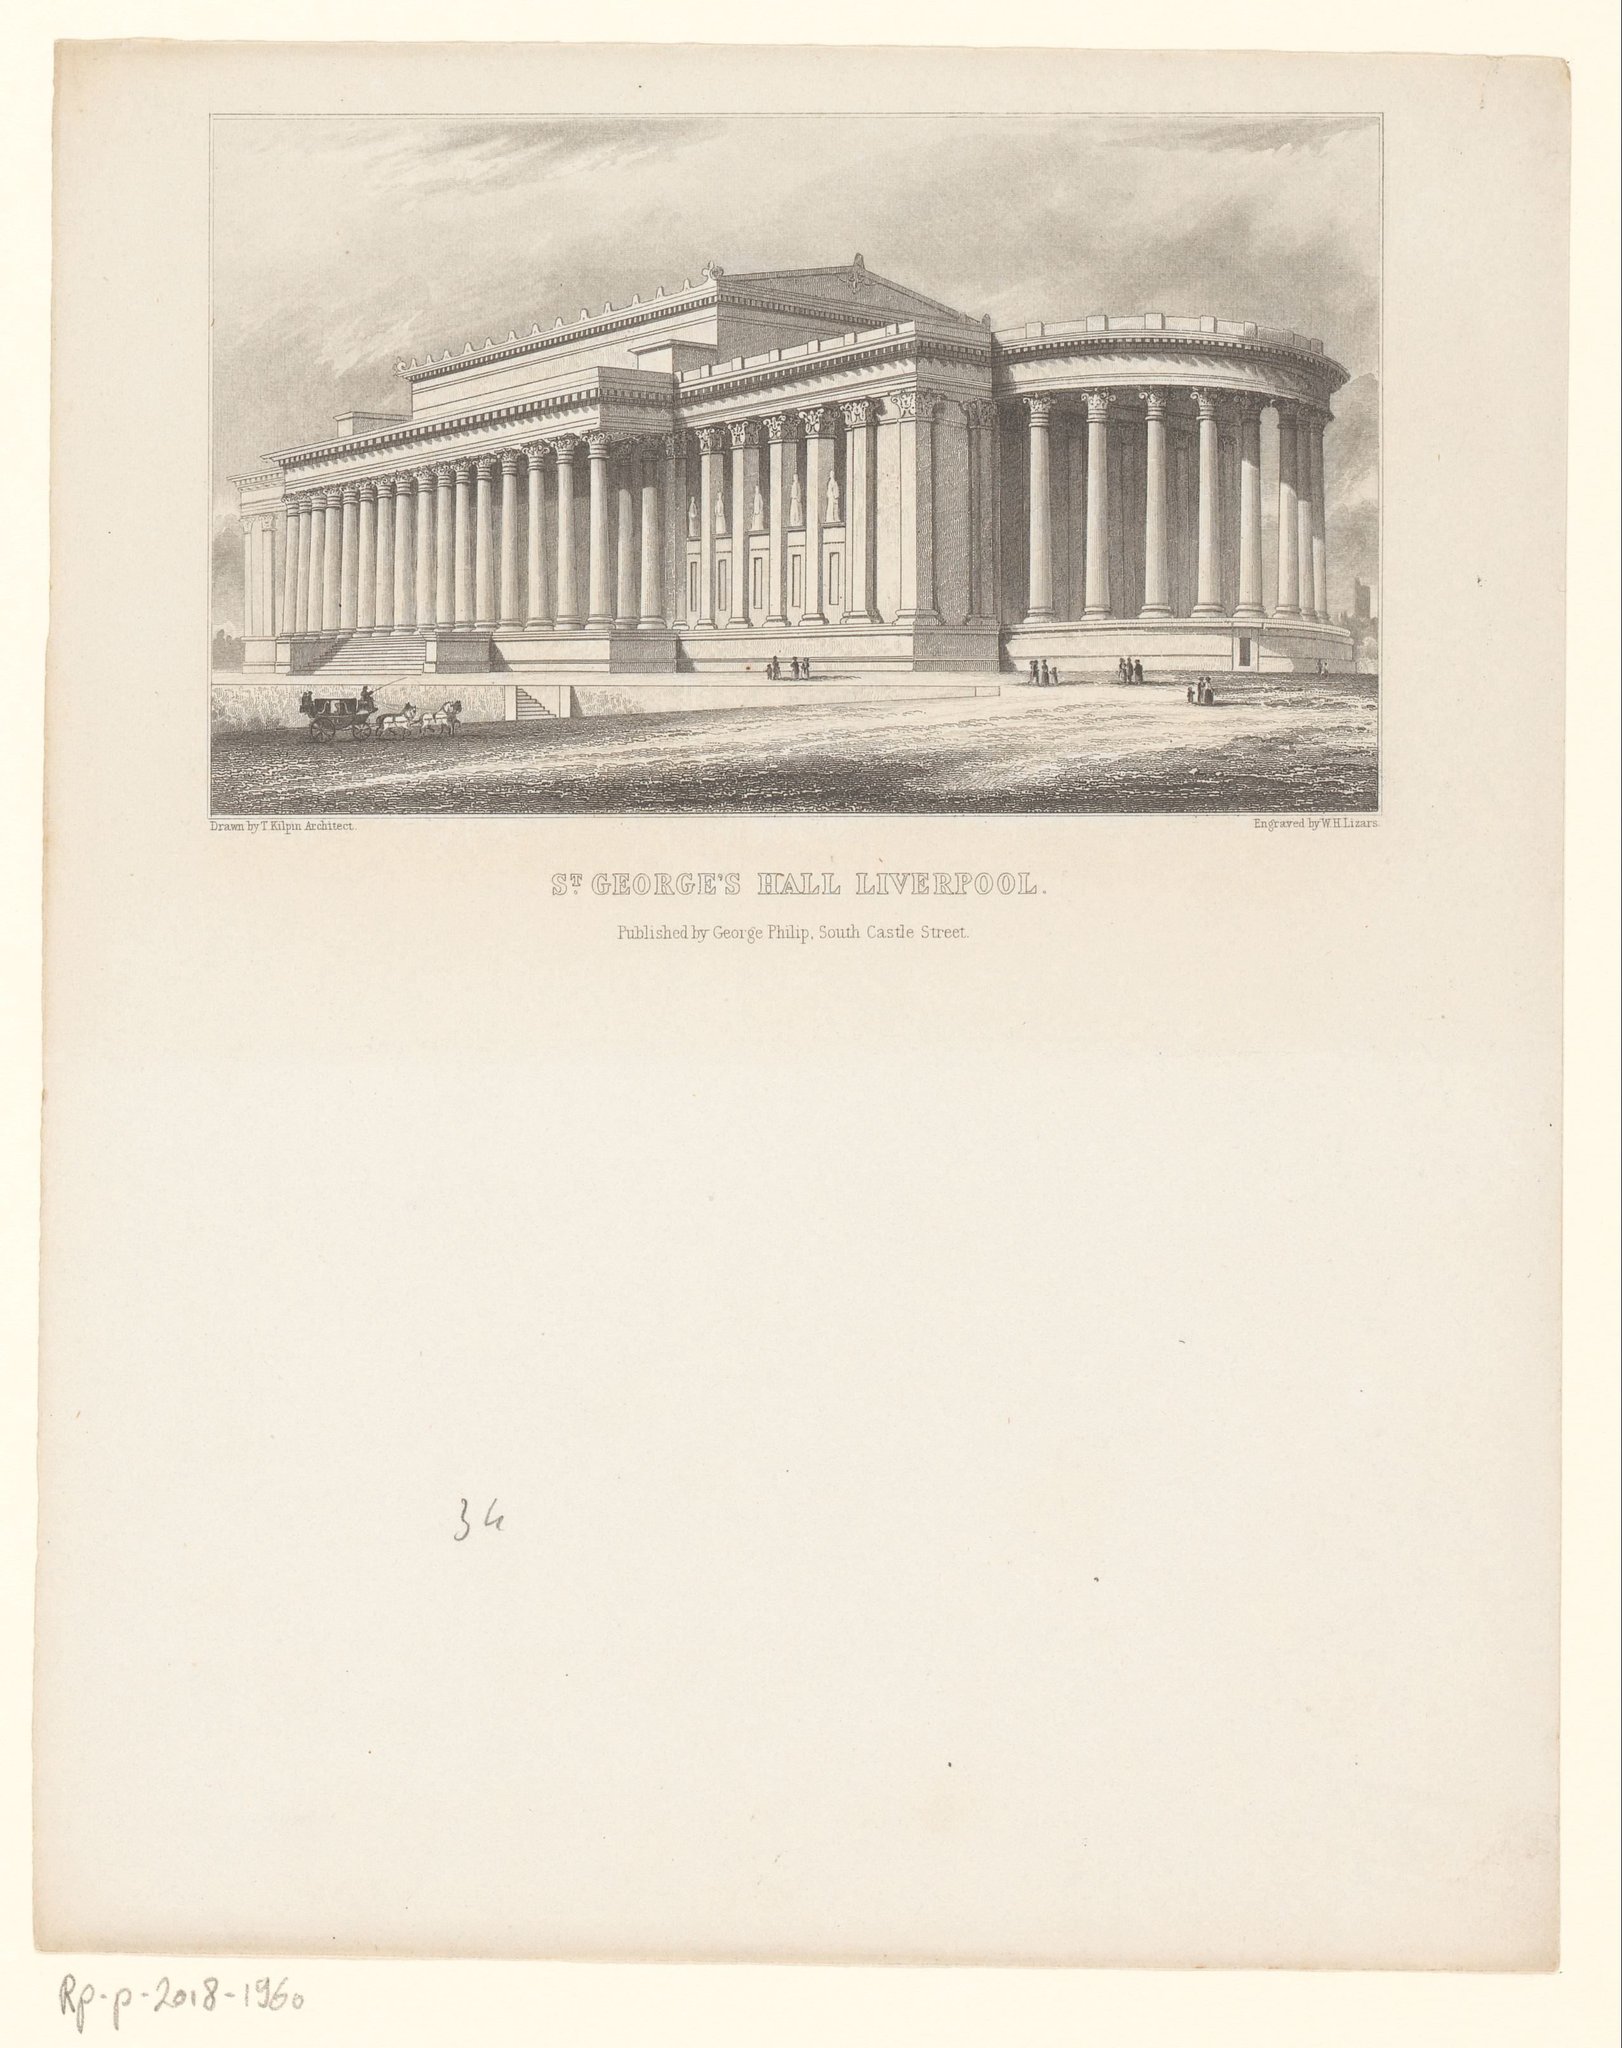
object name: print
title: St. George's Hall Liverpool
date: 1834-1848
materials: paper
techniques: engraving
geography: liverpool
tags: concert hall, edifice, e.g.: public building, department store, liverpool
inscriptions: collector's mark: Lugt 2228